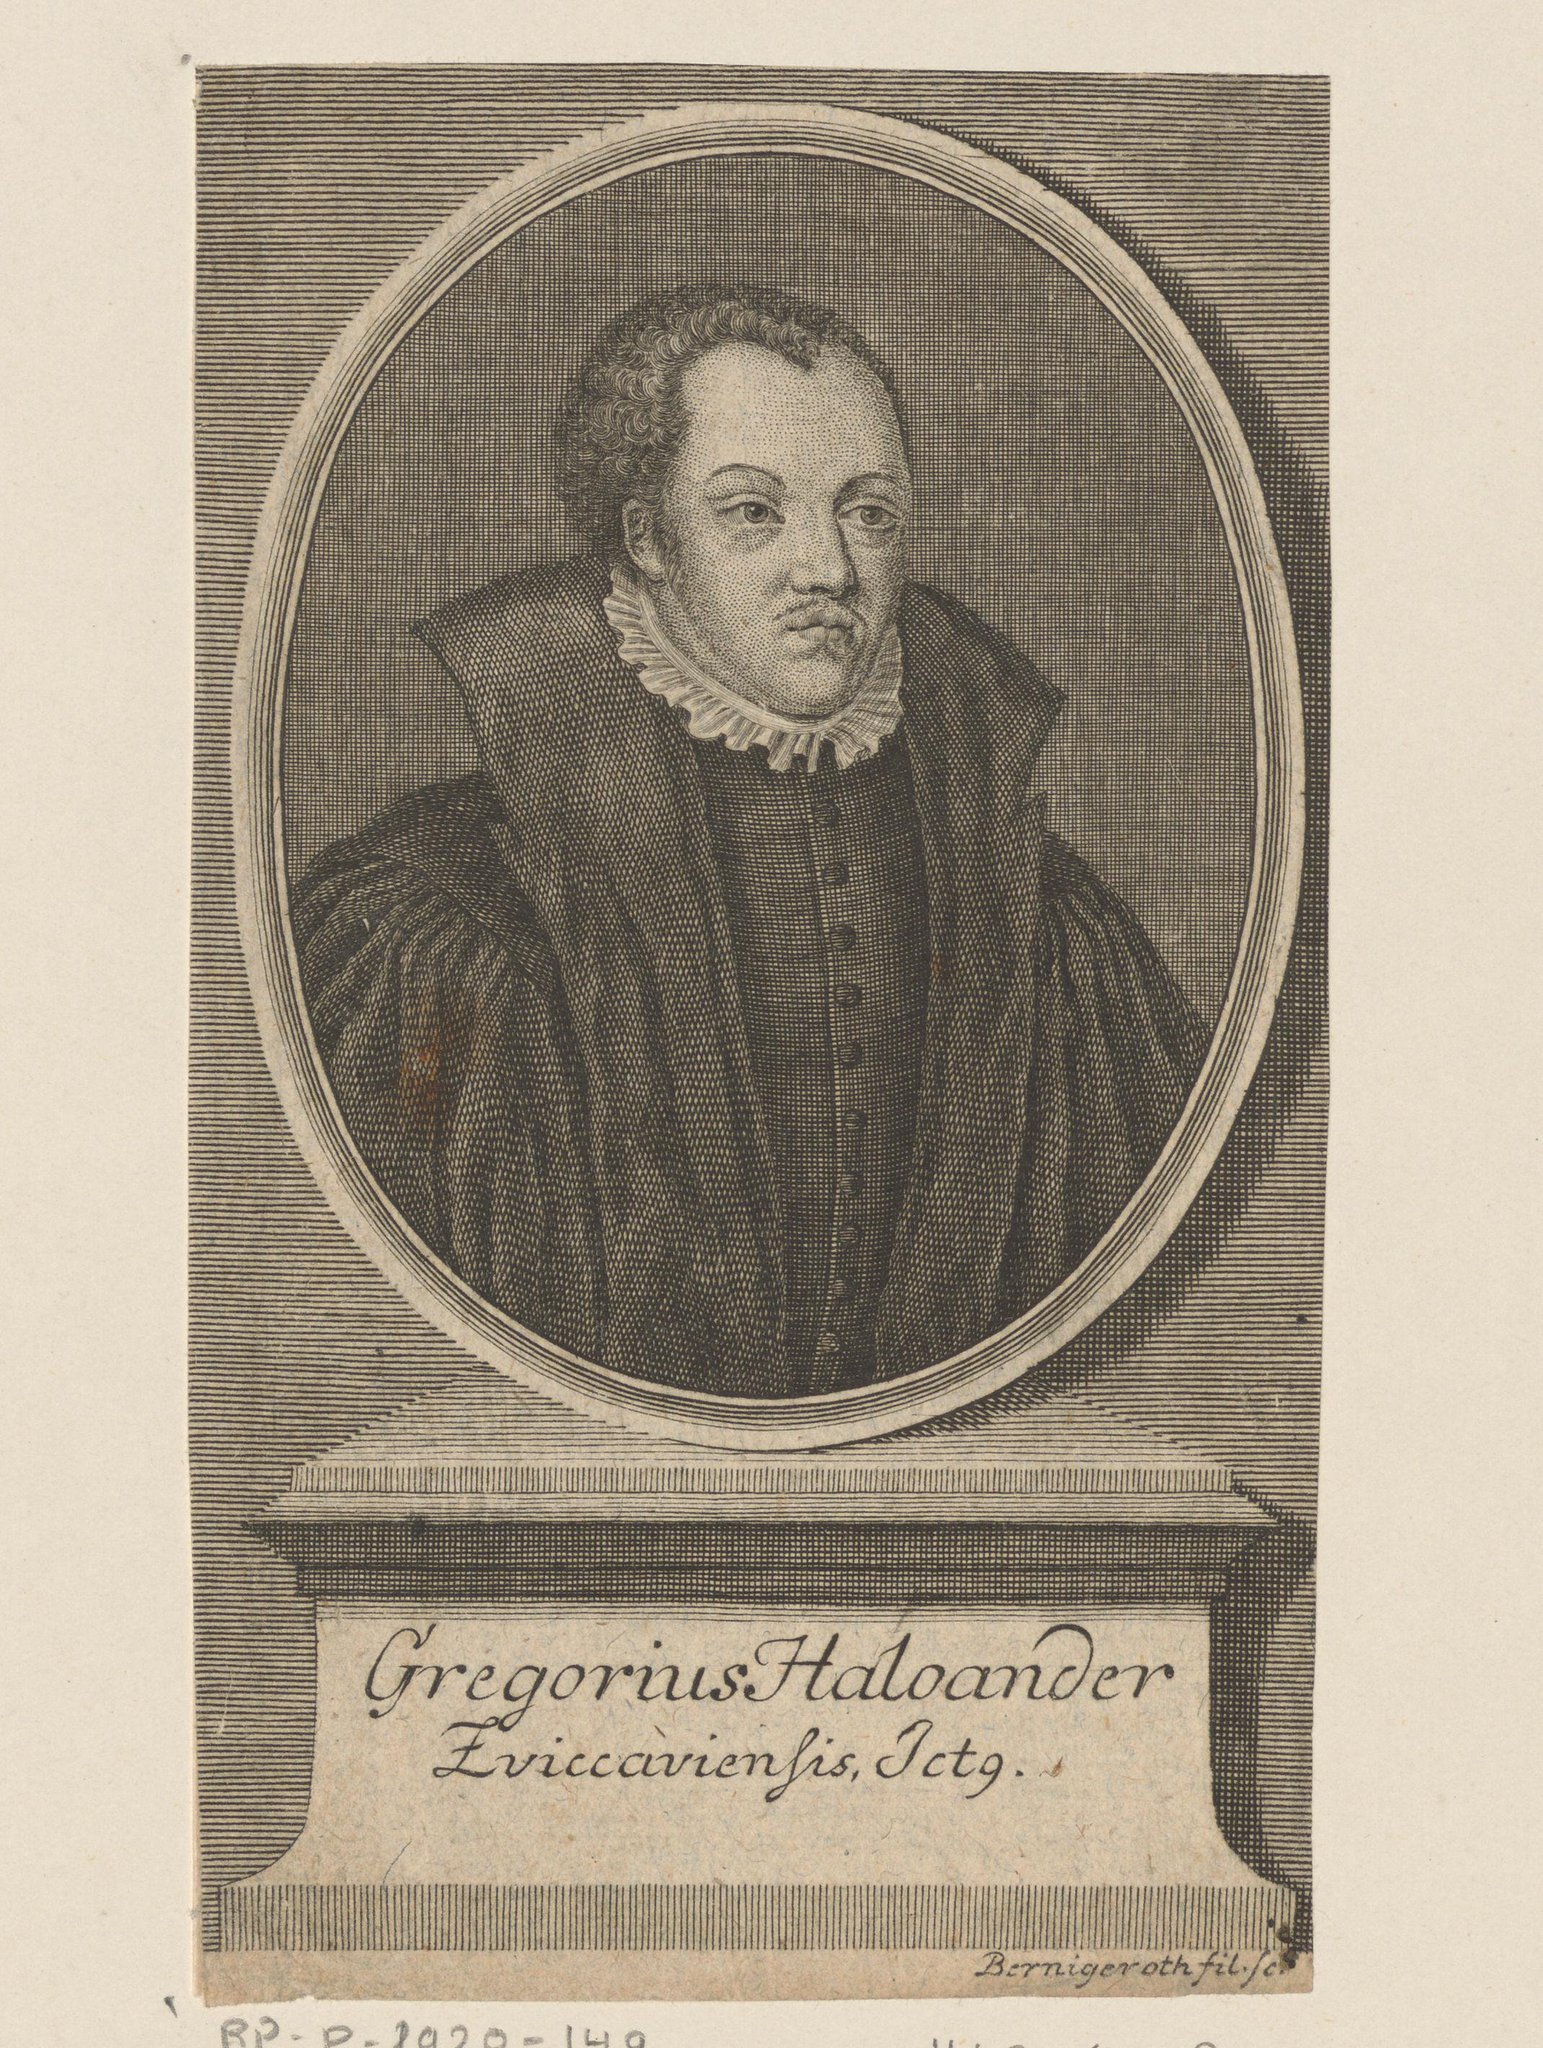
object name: print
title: Portret van Gregor Haloander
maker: johann martin bernigeroth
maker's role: print maker, publisher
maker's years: 1713-1767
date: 1723-1767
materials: paper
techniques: engraving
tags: zwickau, venice, historical persons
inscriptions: collector's mark: Lugt 2228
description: Prent mogelijk uit: Conrad, Franz Carl. Parerga in quibus antiquitates et historia juris illustrantur (...). Helmstedt: Christian Friedrich Weygand 1735.